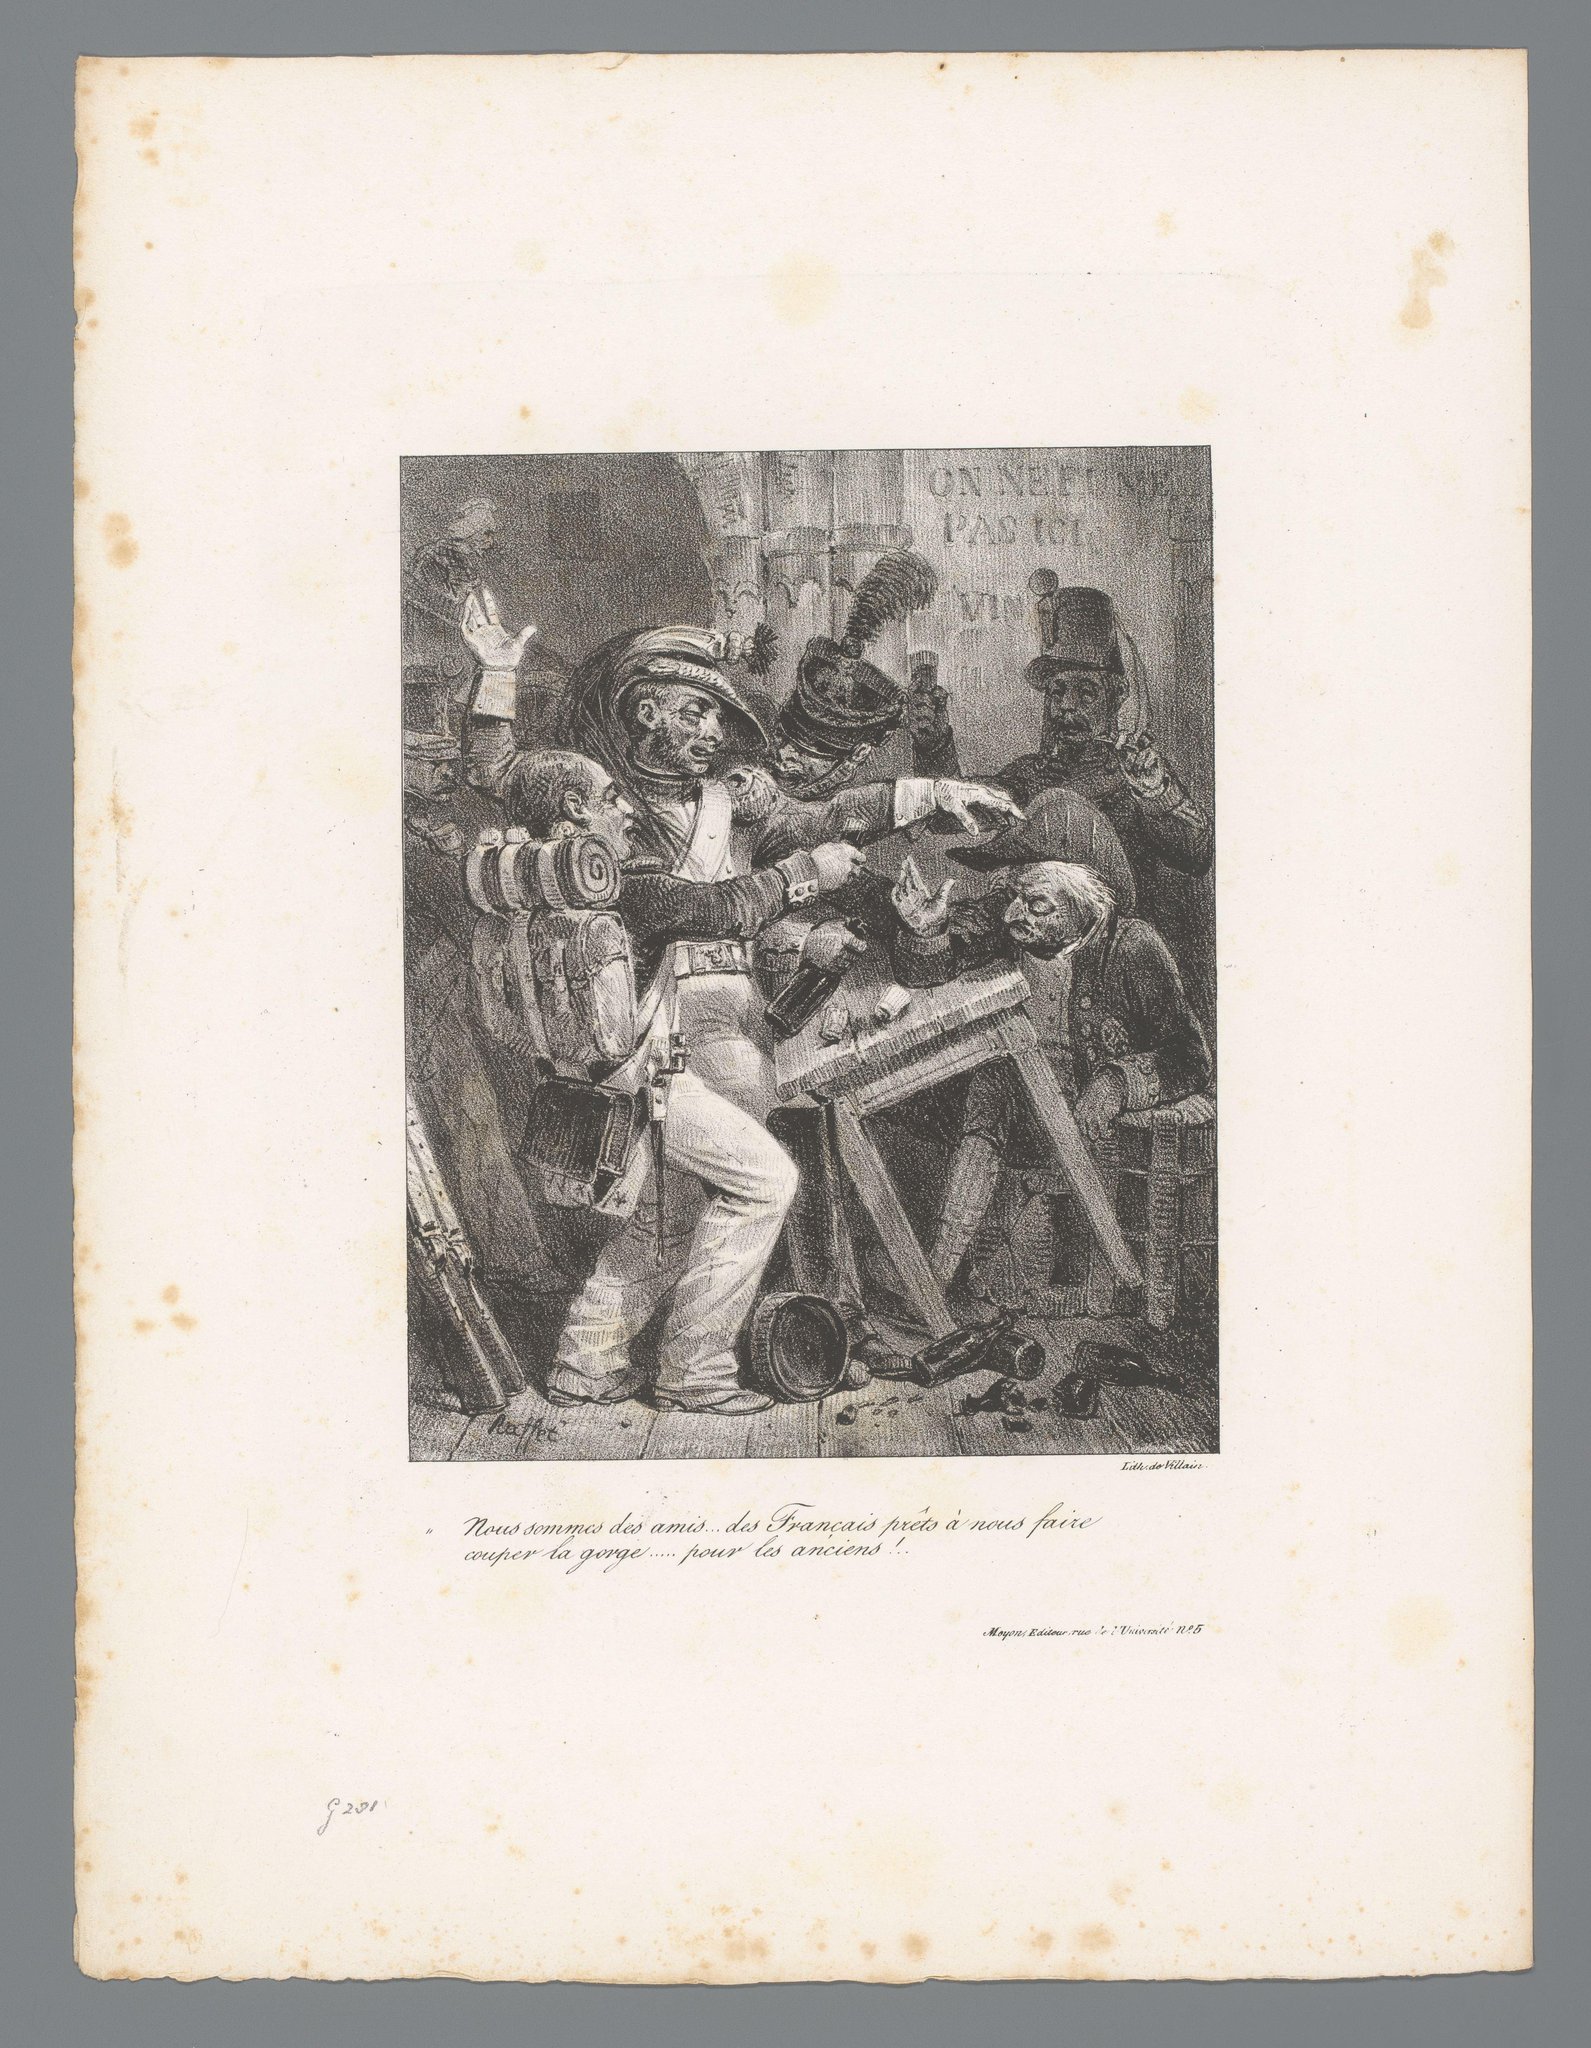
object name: print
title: Nous sommes des amis (...)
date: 1827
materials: paper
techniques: lithograph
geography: paris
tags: veteran, disabilities, deformations, the soldier; the soldier's life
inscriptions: collector's mark: Lugt 964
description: Serie bestaat uit titelprent en tien prenten. Tiende prent in de serie van elf prenten.